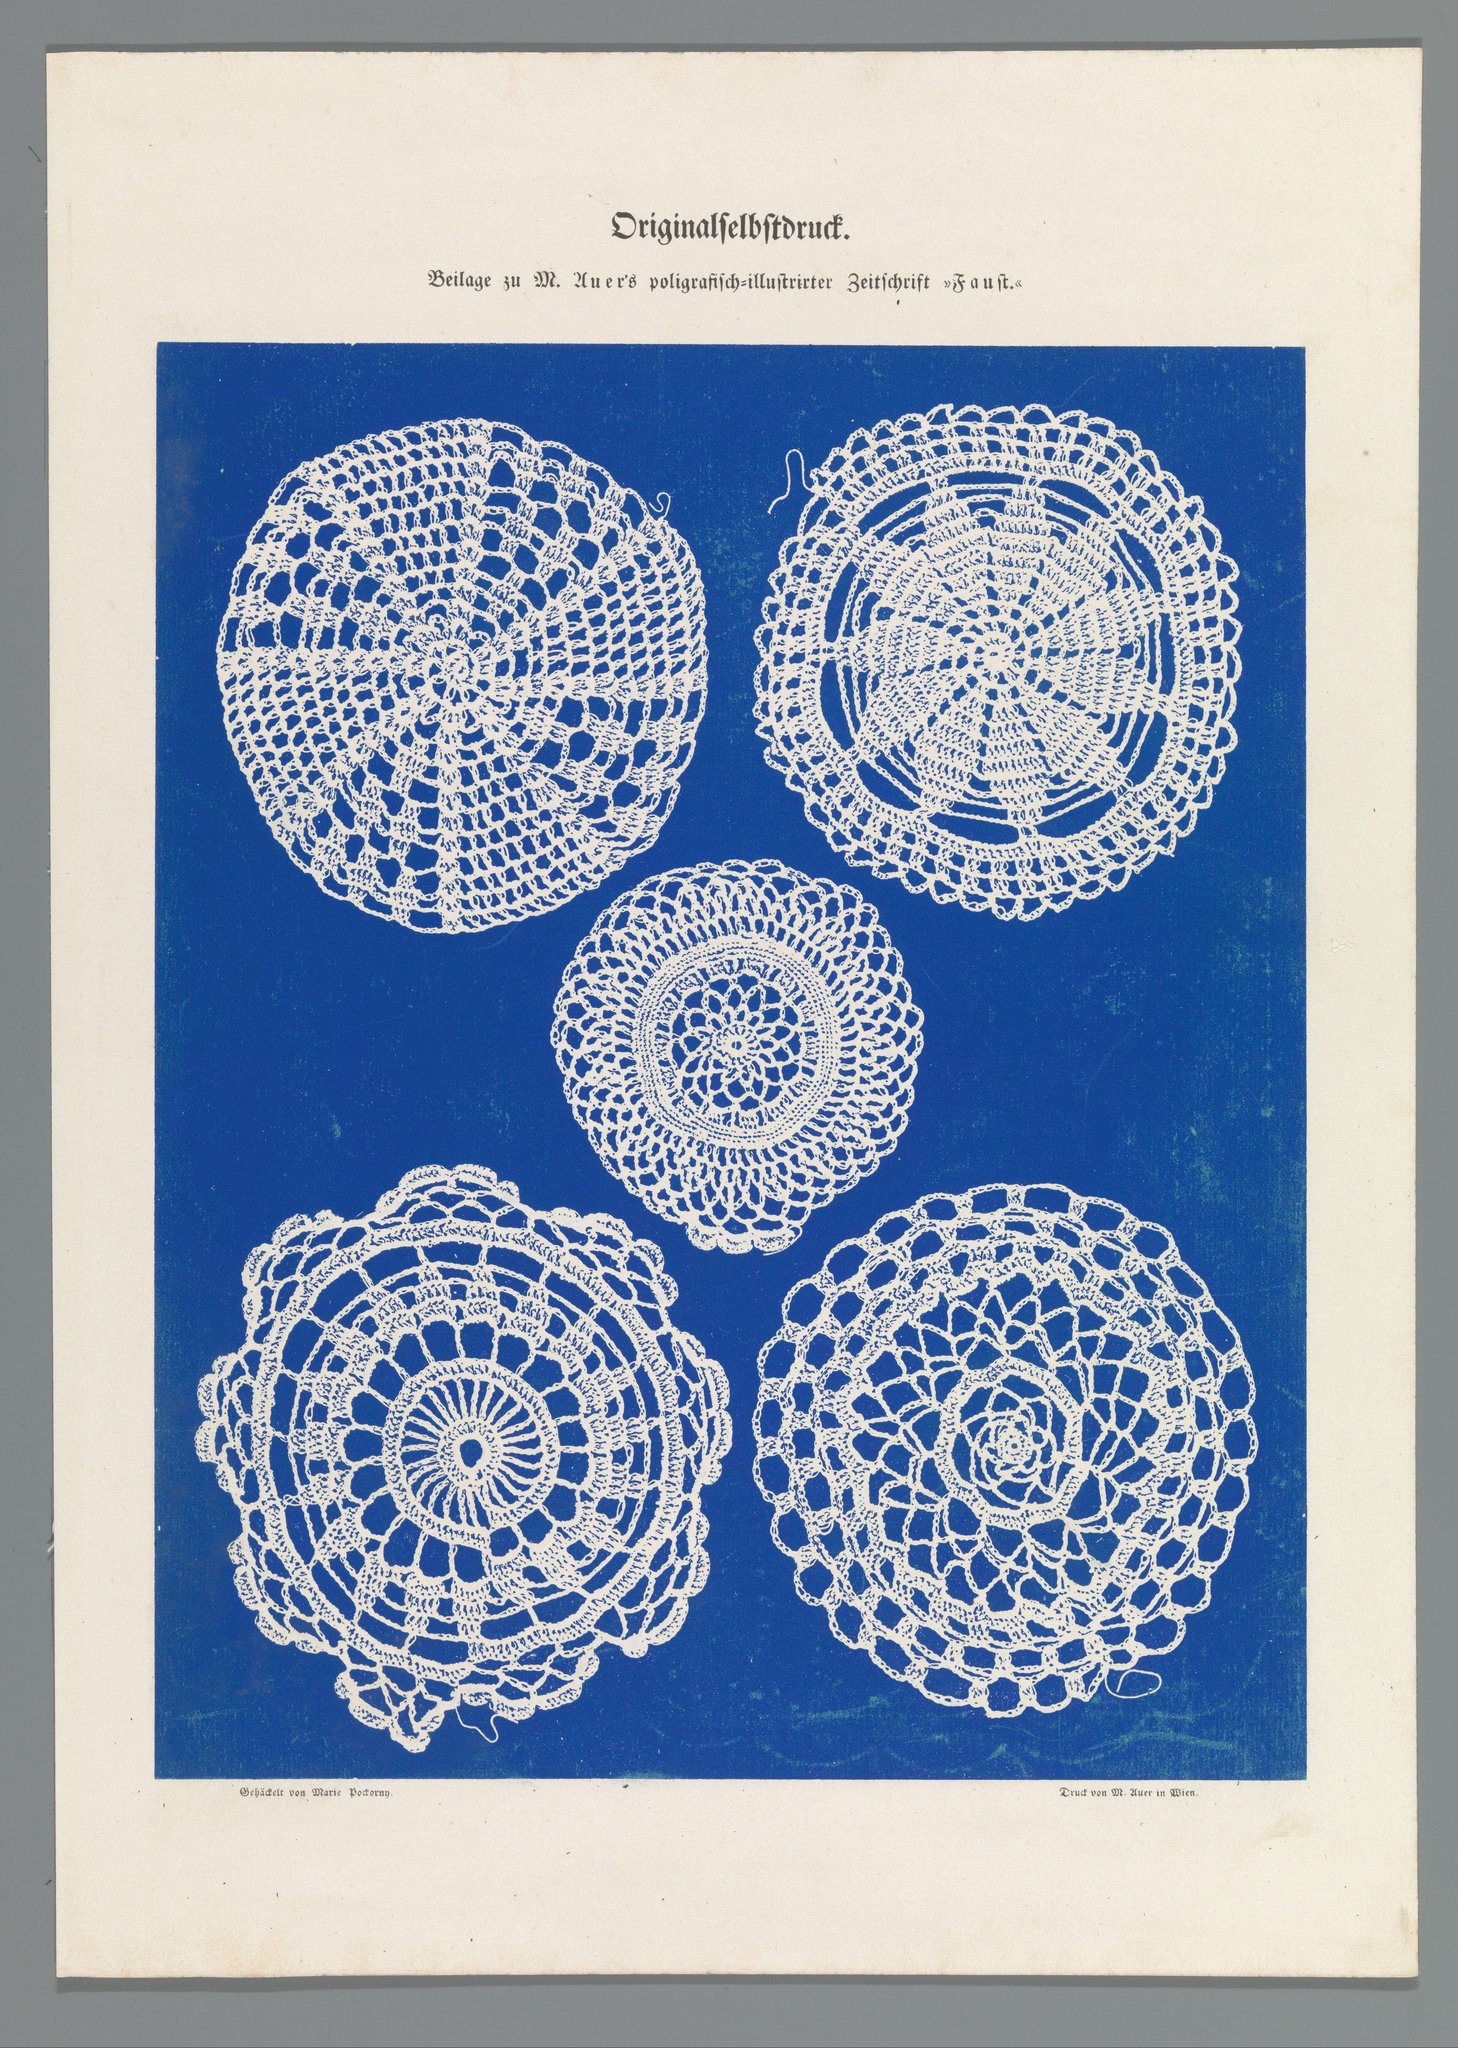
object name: print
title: Vijf kantpatronen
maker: alois ritter von auer von welsbach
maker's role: printer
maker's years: 1813-1869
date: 1855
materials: paper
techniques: nature print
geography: vienna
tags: lace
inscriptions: inscription: ‘Originalselbstdruck./ Beilage zu M. Auer's poligrafisch-illustrirter Zeitschrift "Faust."’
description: Blad uit reeks van 12 Naturselbstdrucke Auer.